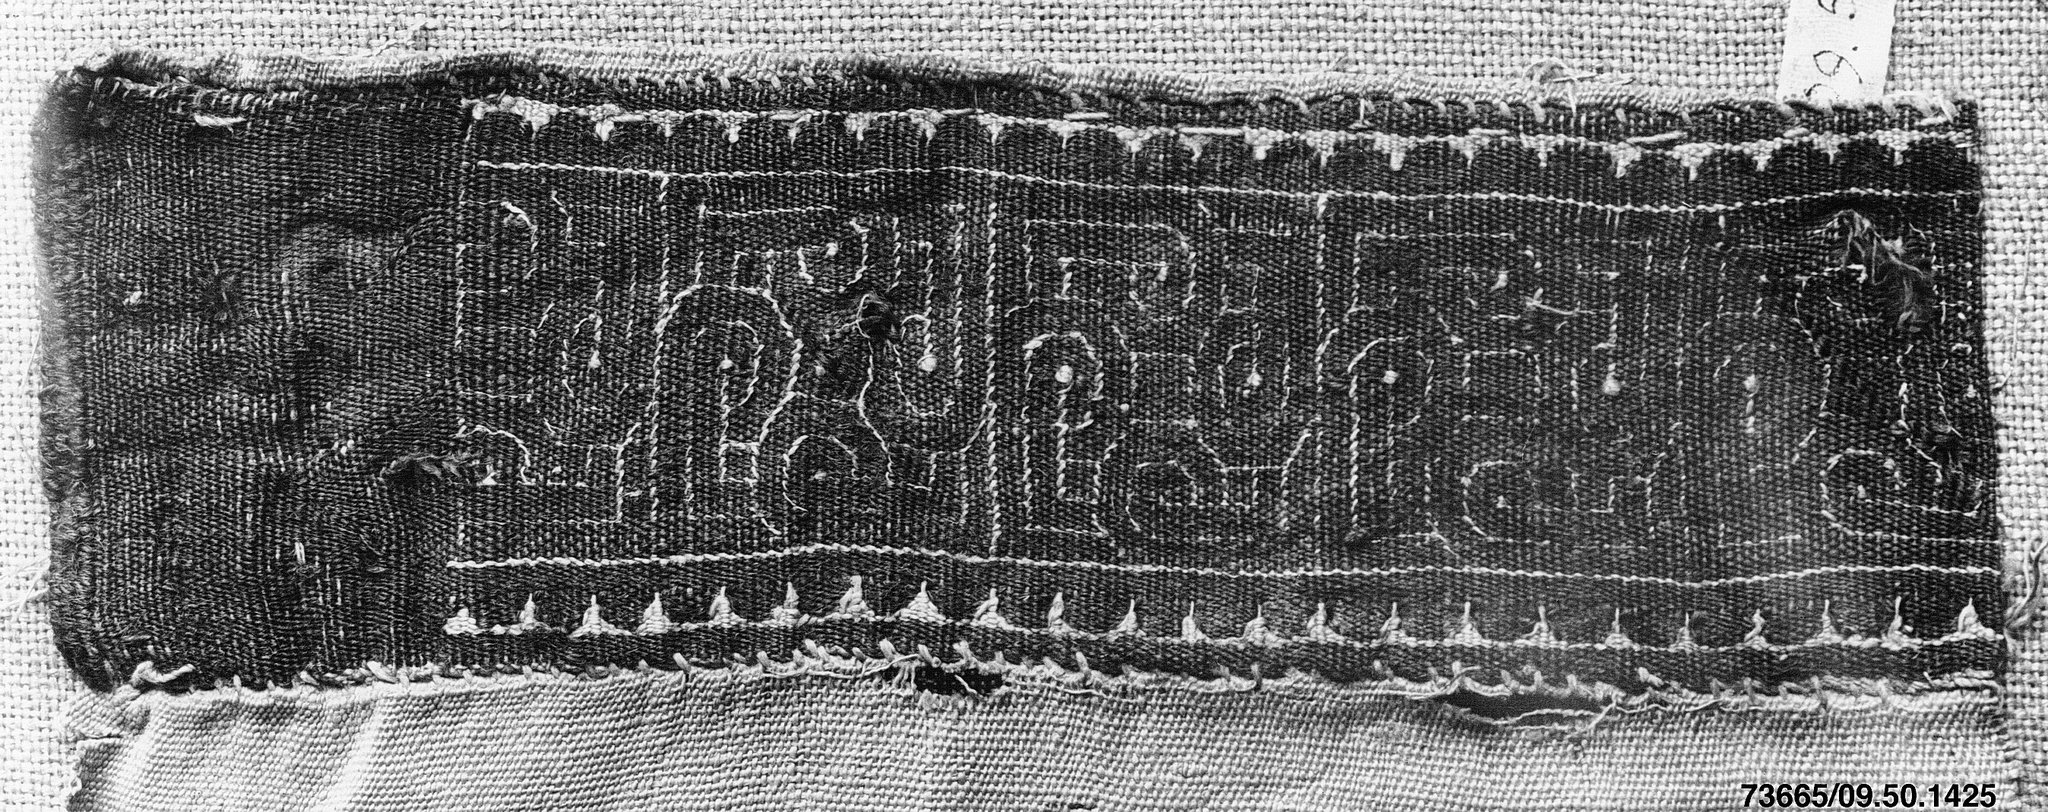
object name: band fragment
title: Fragment of a Band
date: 201-400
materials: linen, wool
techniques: weave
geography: egypt